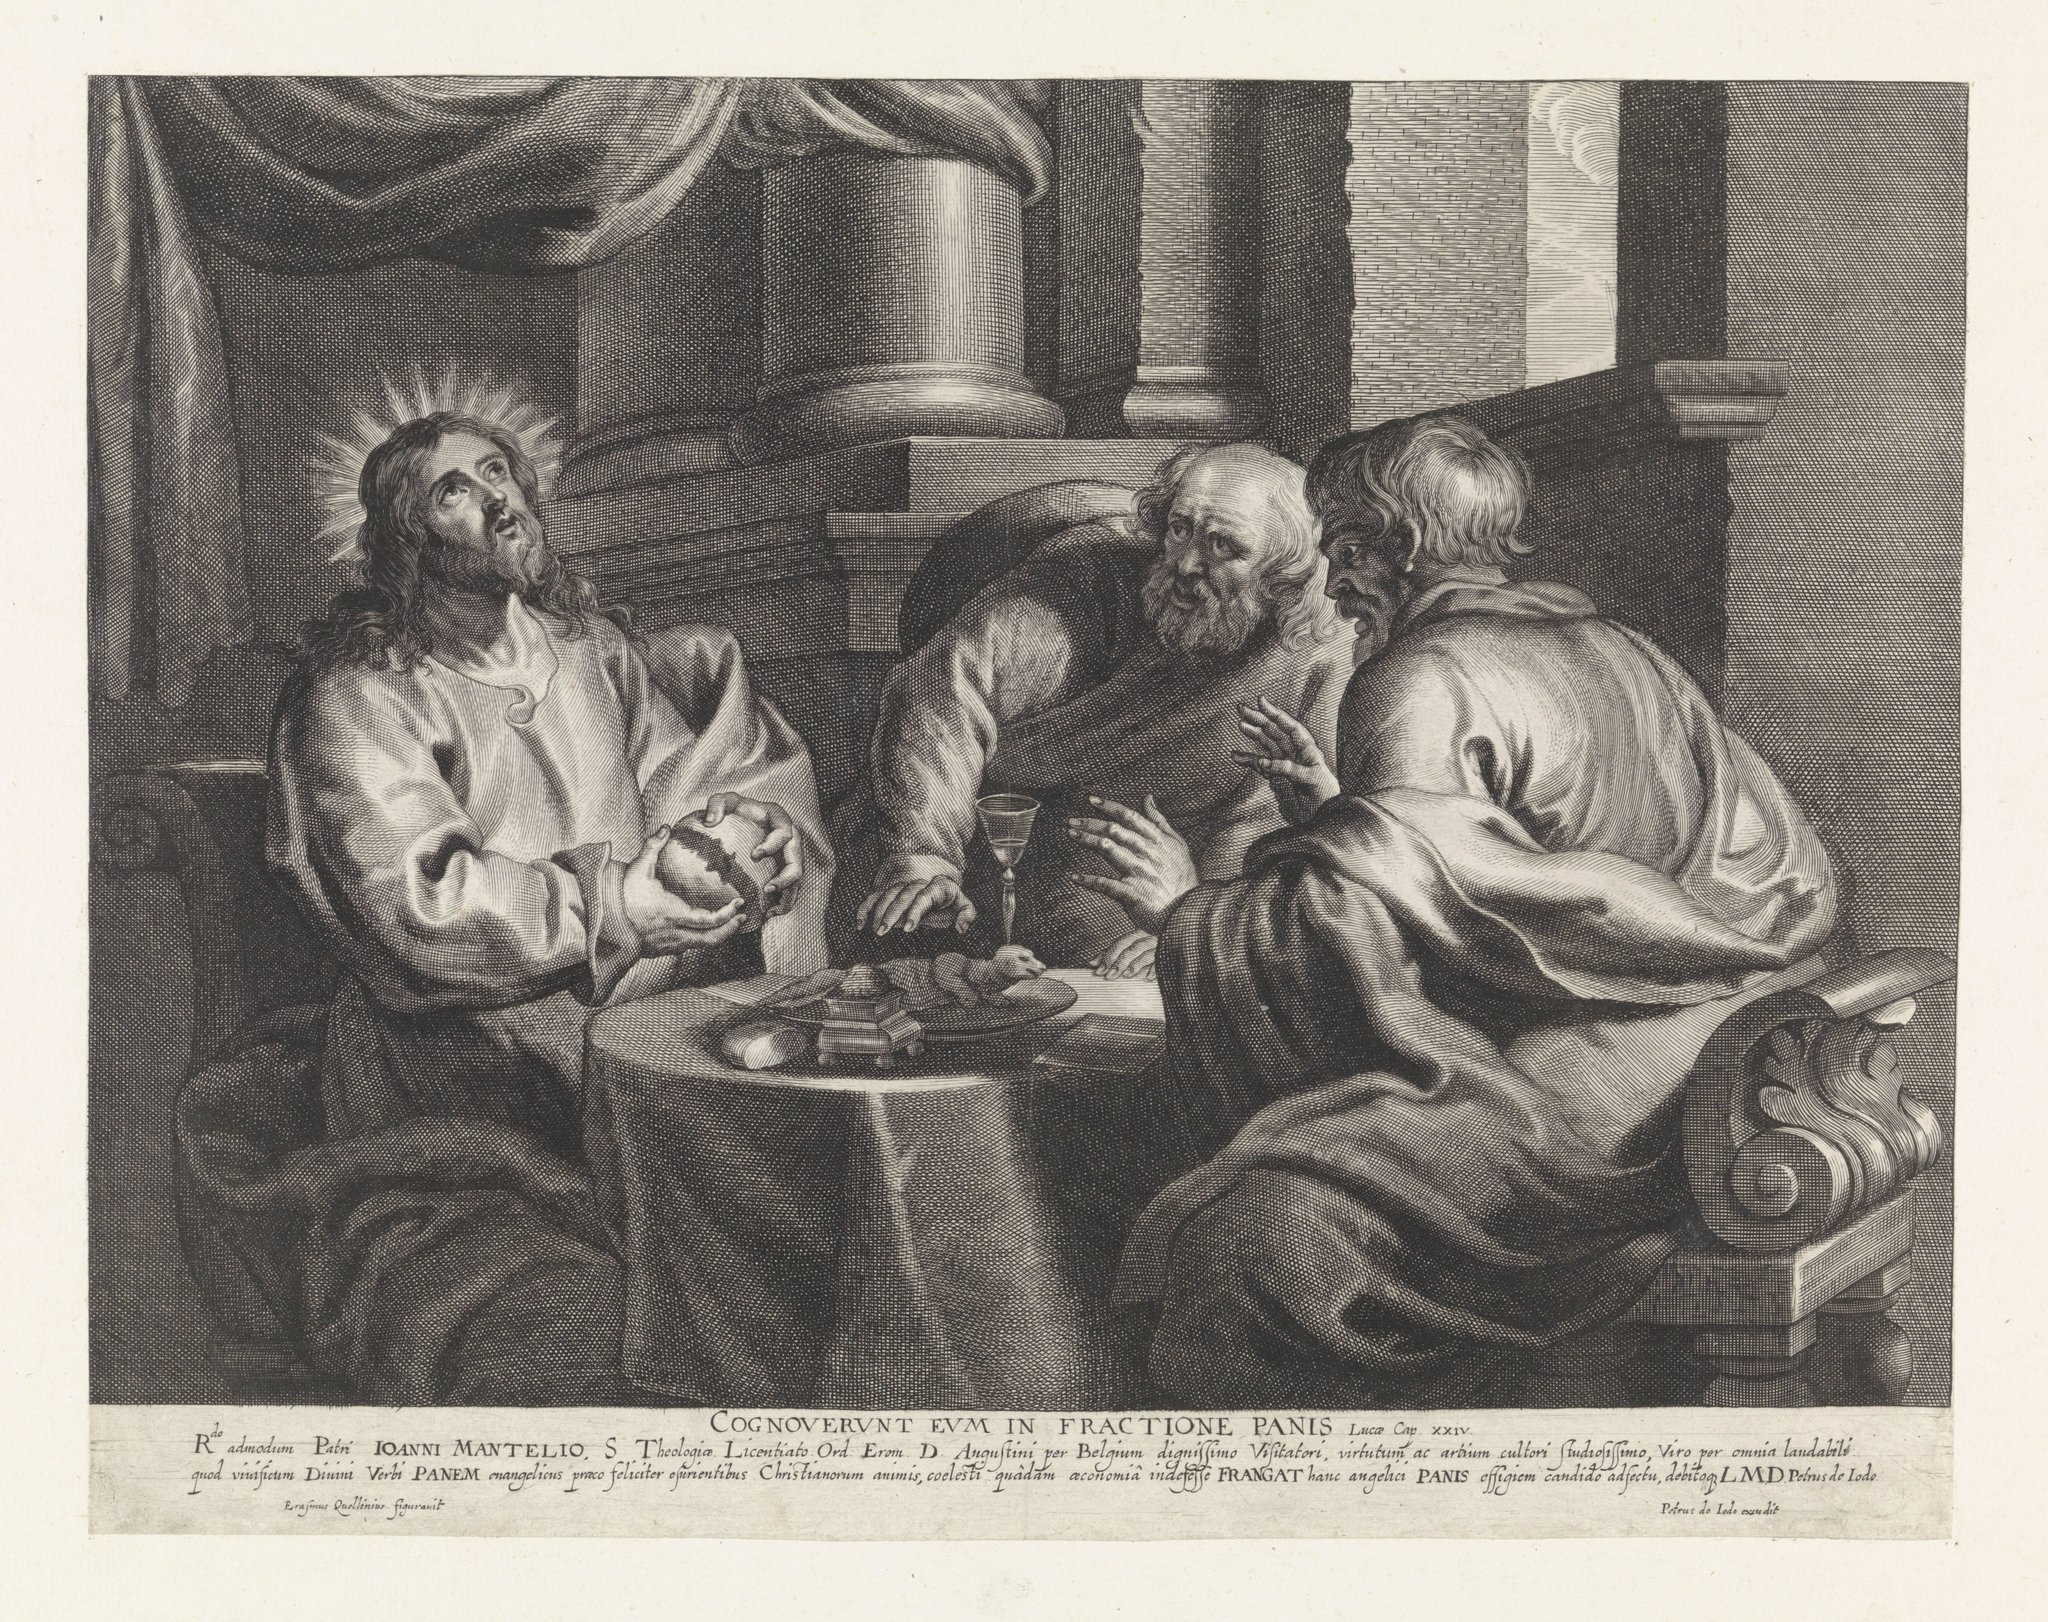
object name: print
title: Maaltijd in Emmaüs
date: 1636-1670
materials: paper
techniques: engraving, etching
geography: antwerp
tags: the supper at emmaus: christ is recognized while blessing or breaking the bread, cleopas and peter meet christ (sometimes they are dressed as pilgrims)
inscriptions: collector's mark: Lugt 240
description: Interieur met Christus en twee apostelen, zittend rond een tafel. Christus breekt het brood en maakt zo zijn identiteit kenbaar. De twee apostelen kijken geschokt. In de marge een onderschrift in het Latijn.